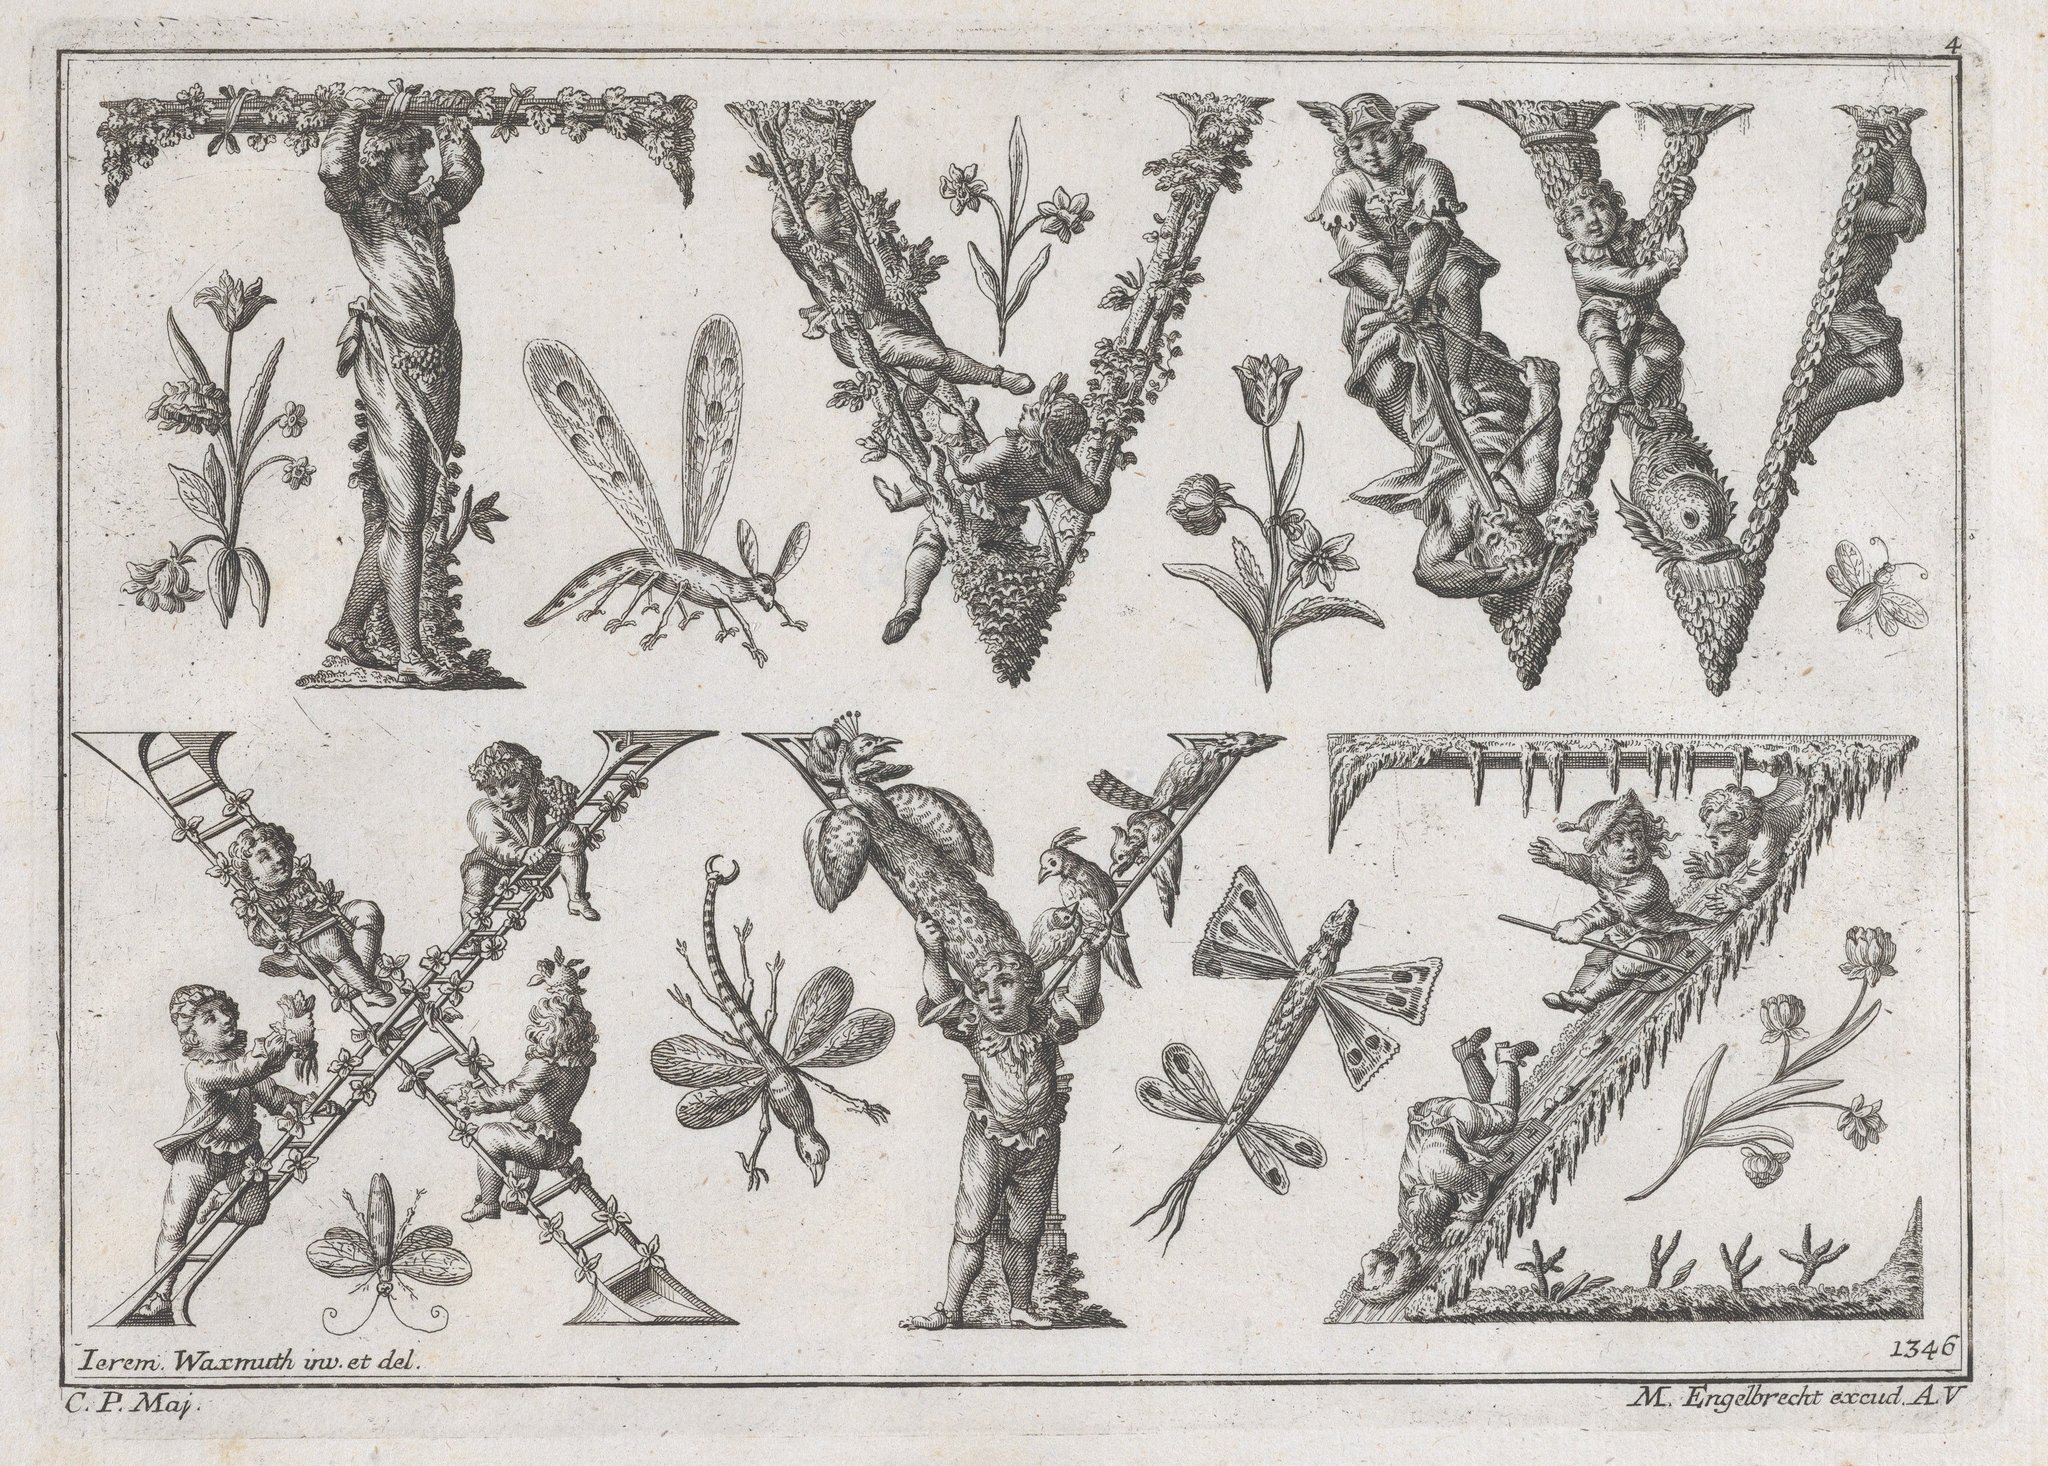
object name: print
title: Decorated Roman alphabet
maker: jeremias wachsmuth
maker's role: artist and engraver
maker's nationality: german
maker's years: 1712-1771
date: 1701-1800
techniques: engraving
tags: boys,men,flowers